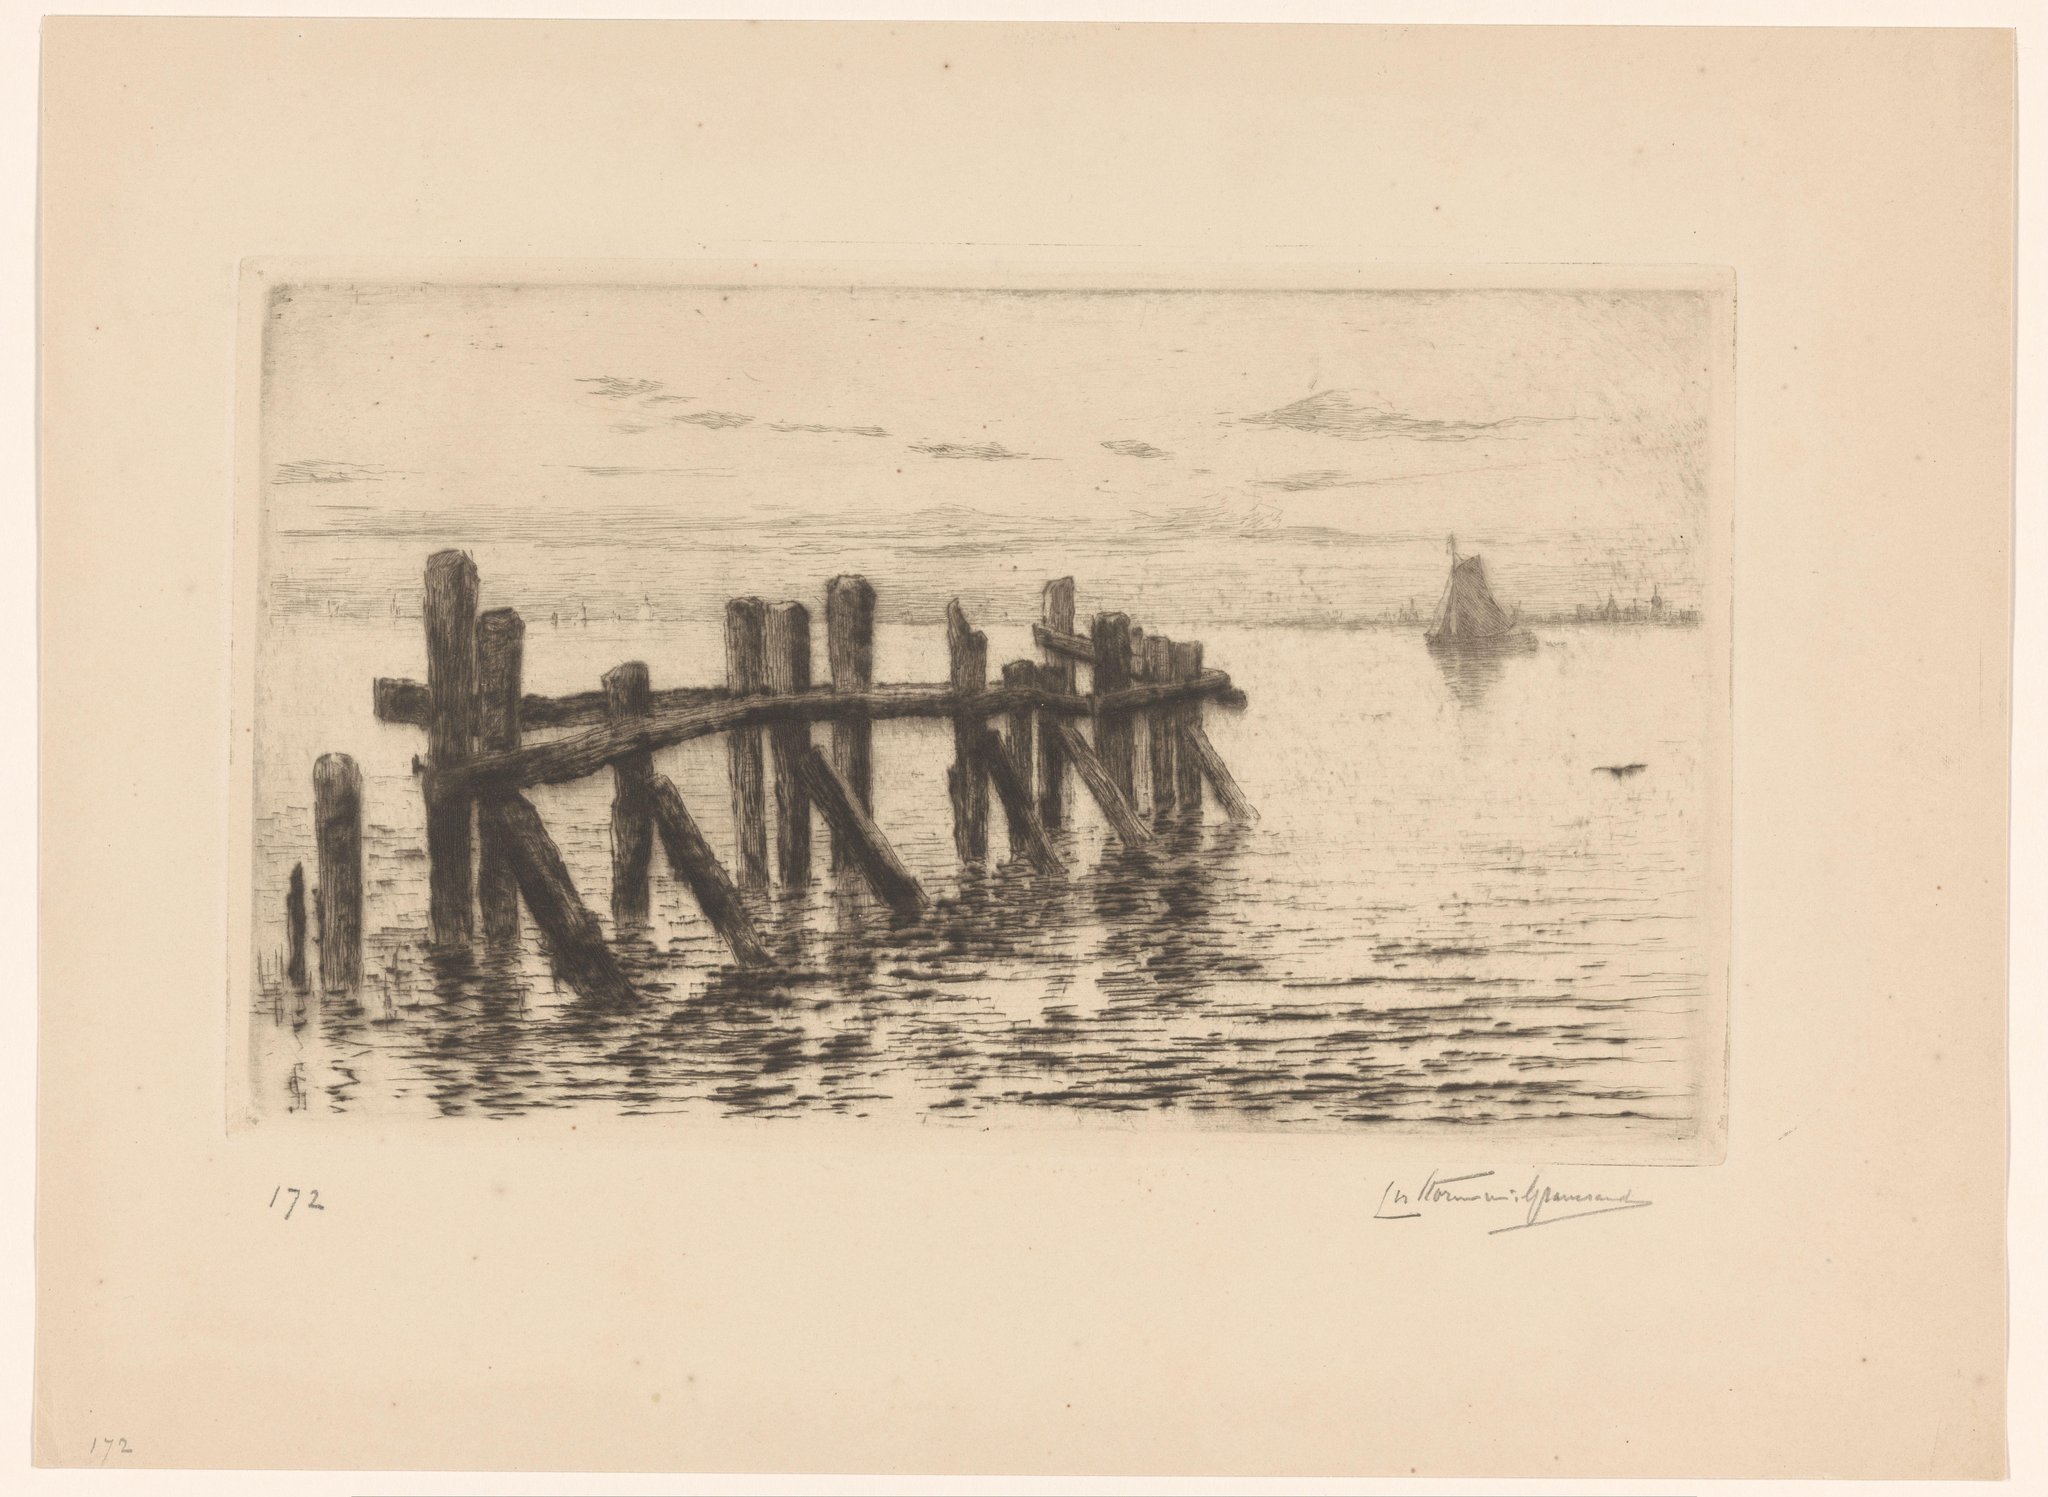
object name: print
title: Bords de l'Y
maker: carel nicolaas storm van s-gravesande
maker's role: draughtsman, print maker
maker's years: 1841-1924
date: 1880-1884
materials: paper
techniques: drypoint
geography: netherlands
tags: pier, quay, wharf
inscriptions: collector's mark: Lugt 2228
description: Op verso is een deel van een andere prent te zien.